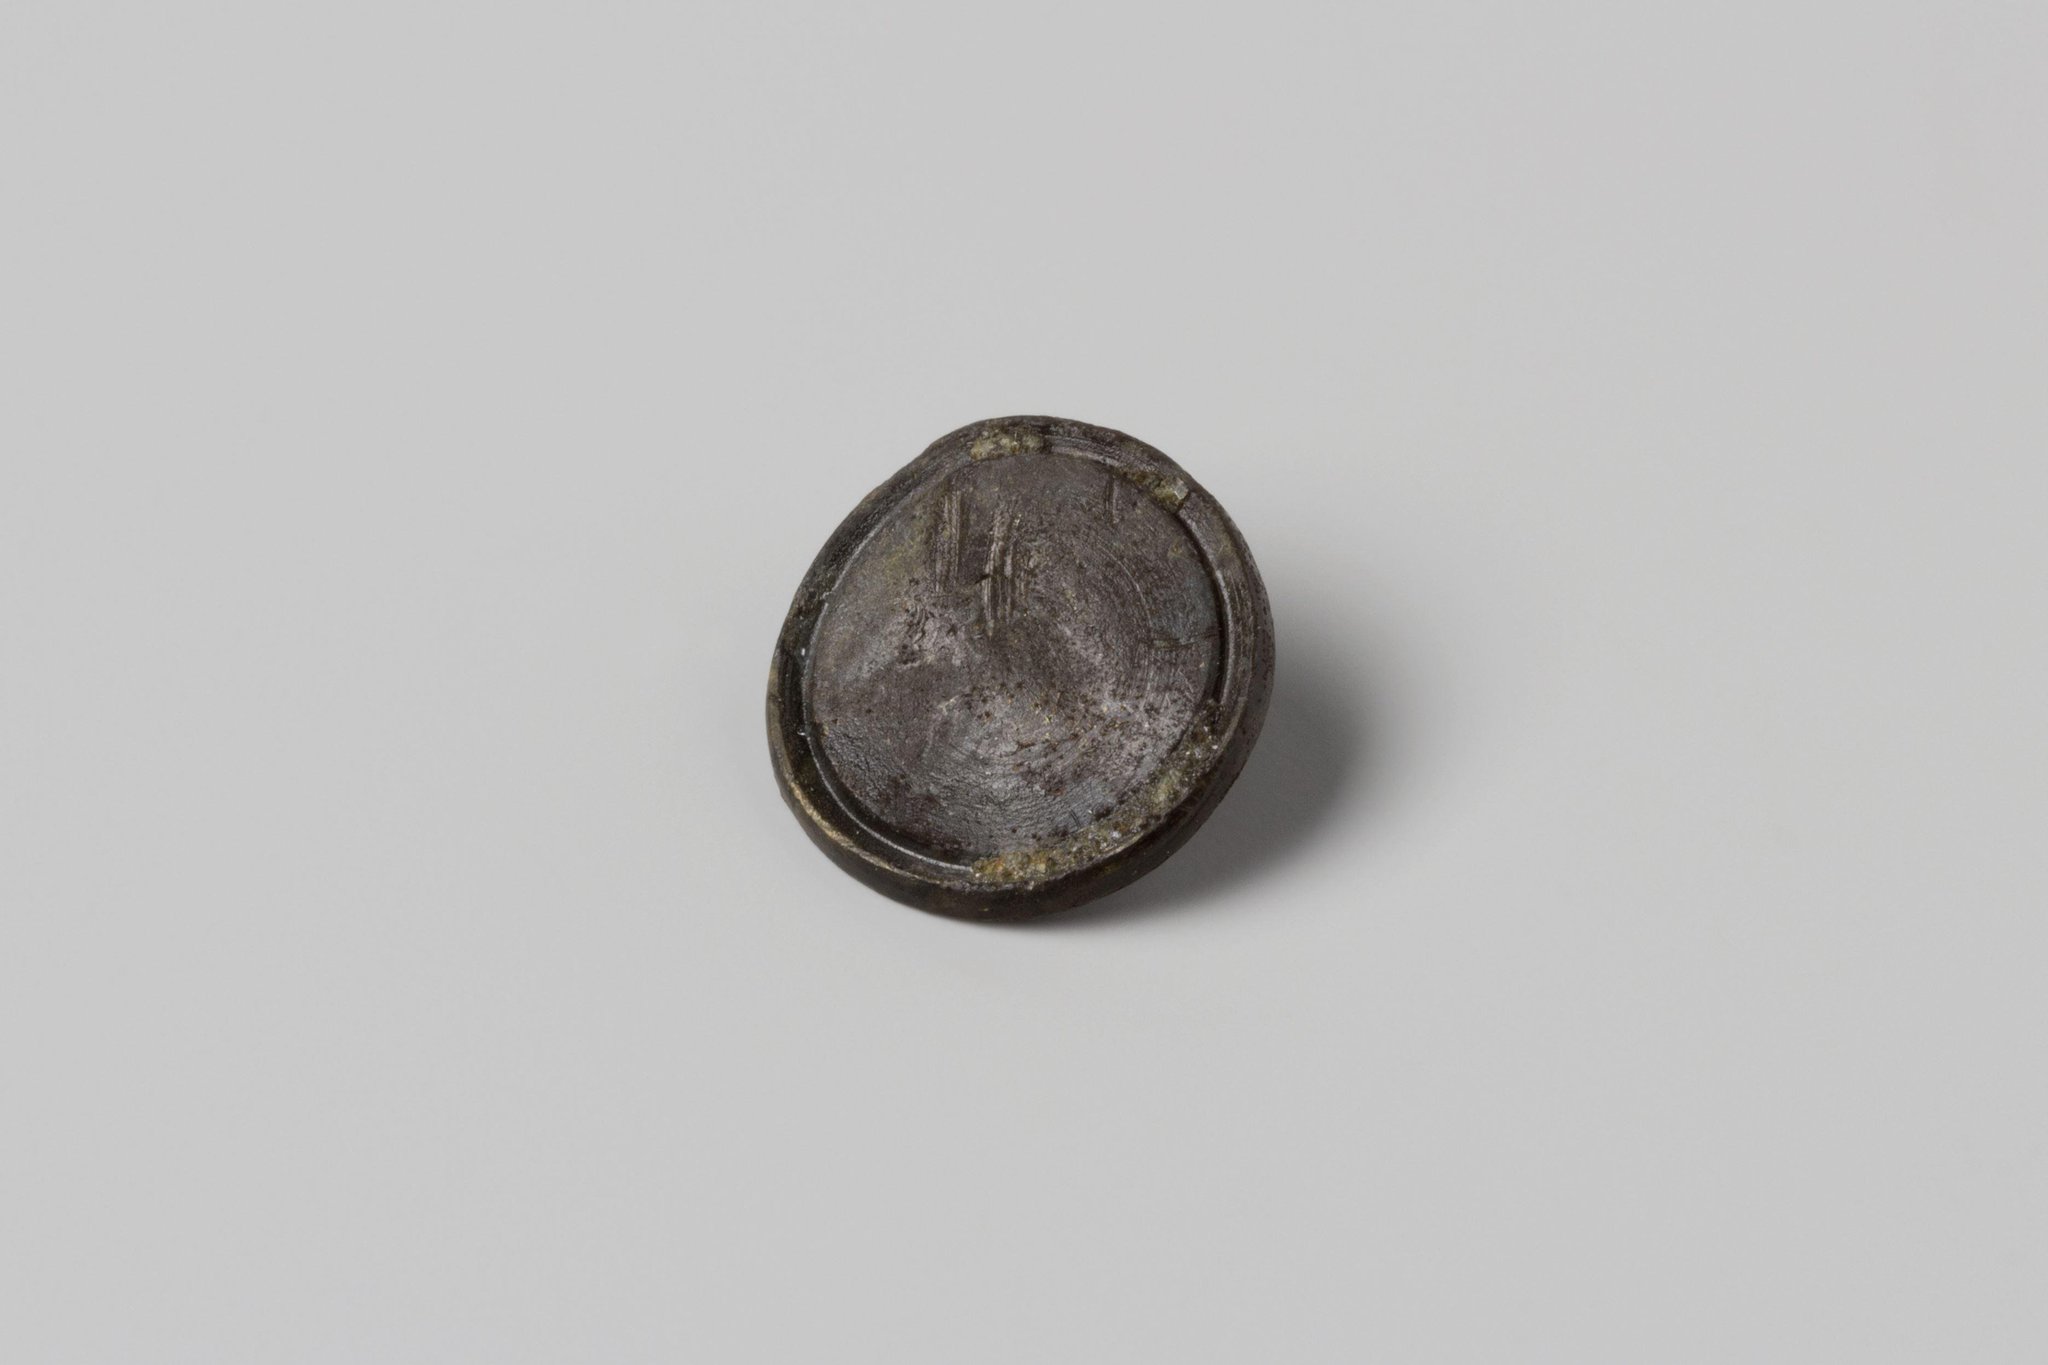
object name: button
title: Knoop uit het wrak van de Oost-Indiëvaarder Hollandia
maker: Anonymous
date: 1700-1743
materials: copper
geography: netherlands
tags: verenigde oostindische compagnie, hollandia (schip), annet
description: Knoop. (1) flat, plain, concentric groove along rim (1.4d, 0.1t), key-shank